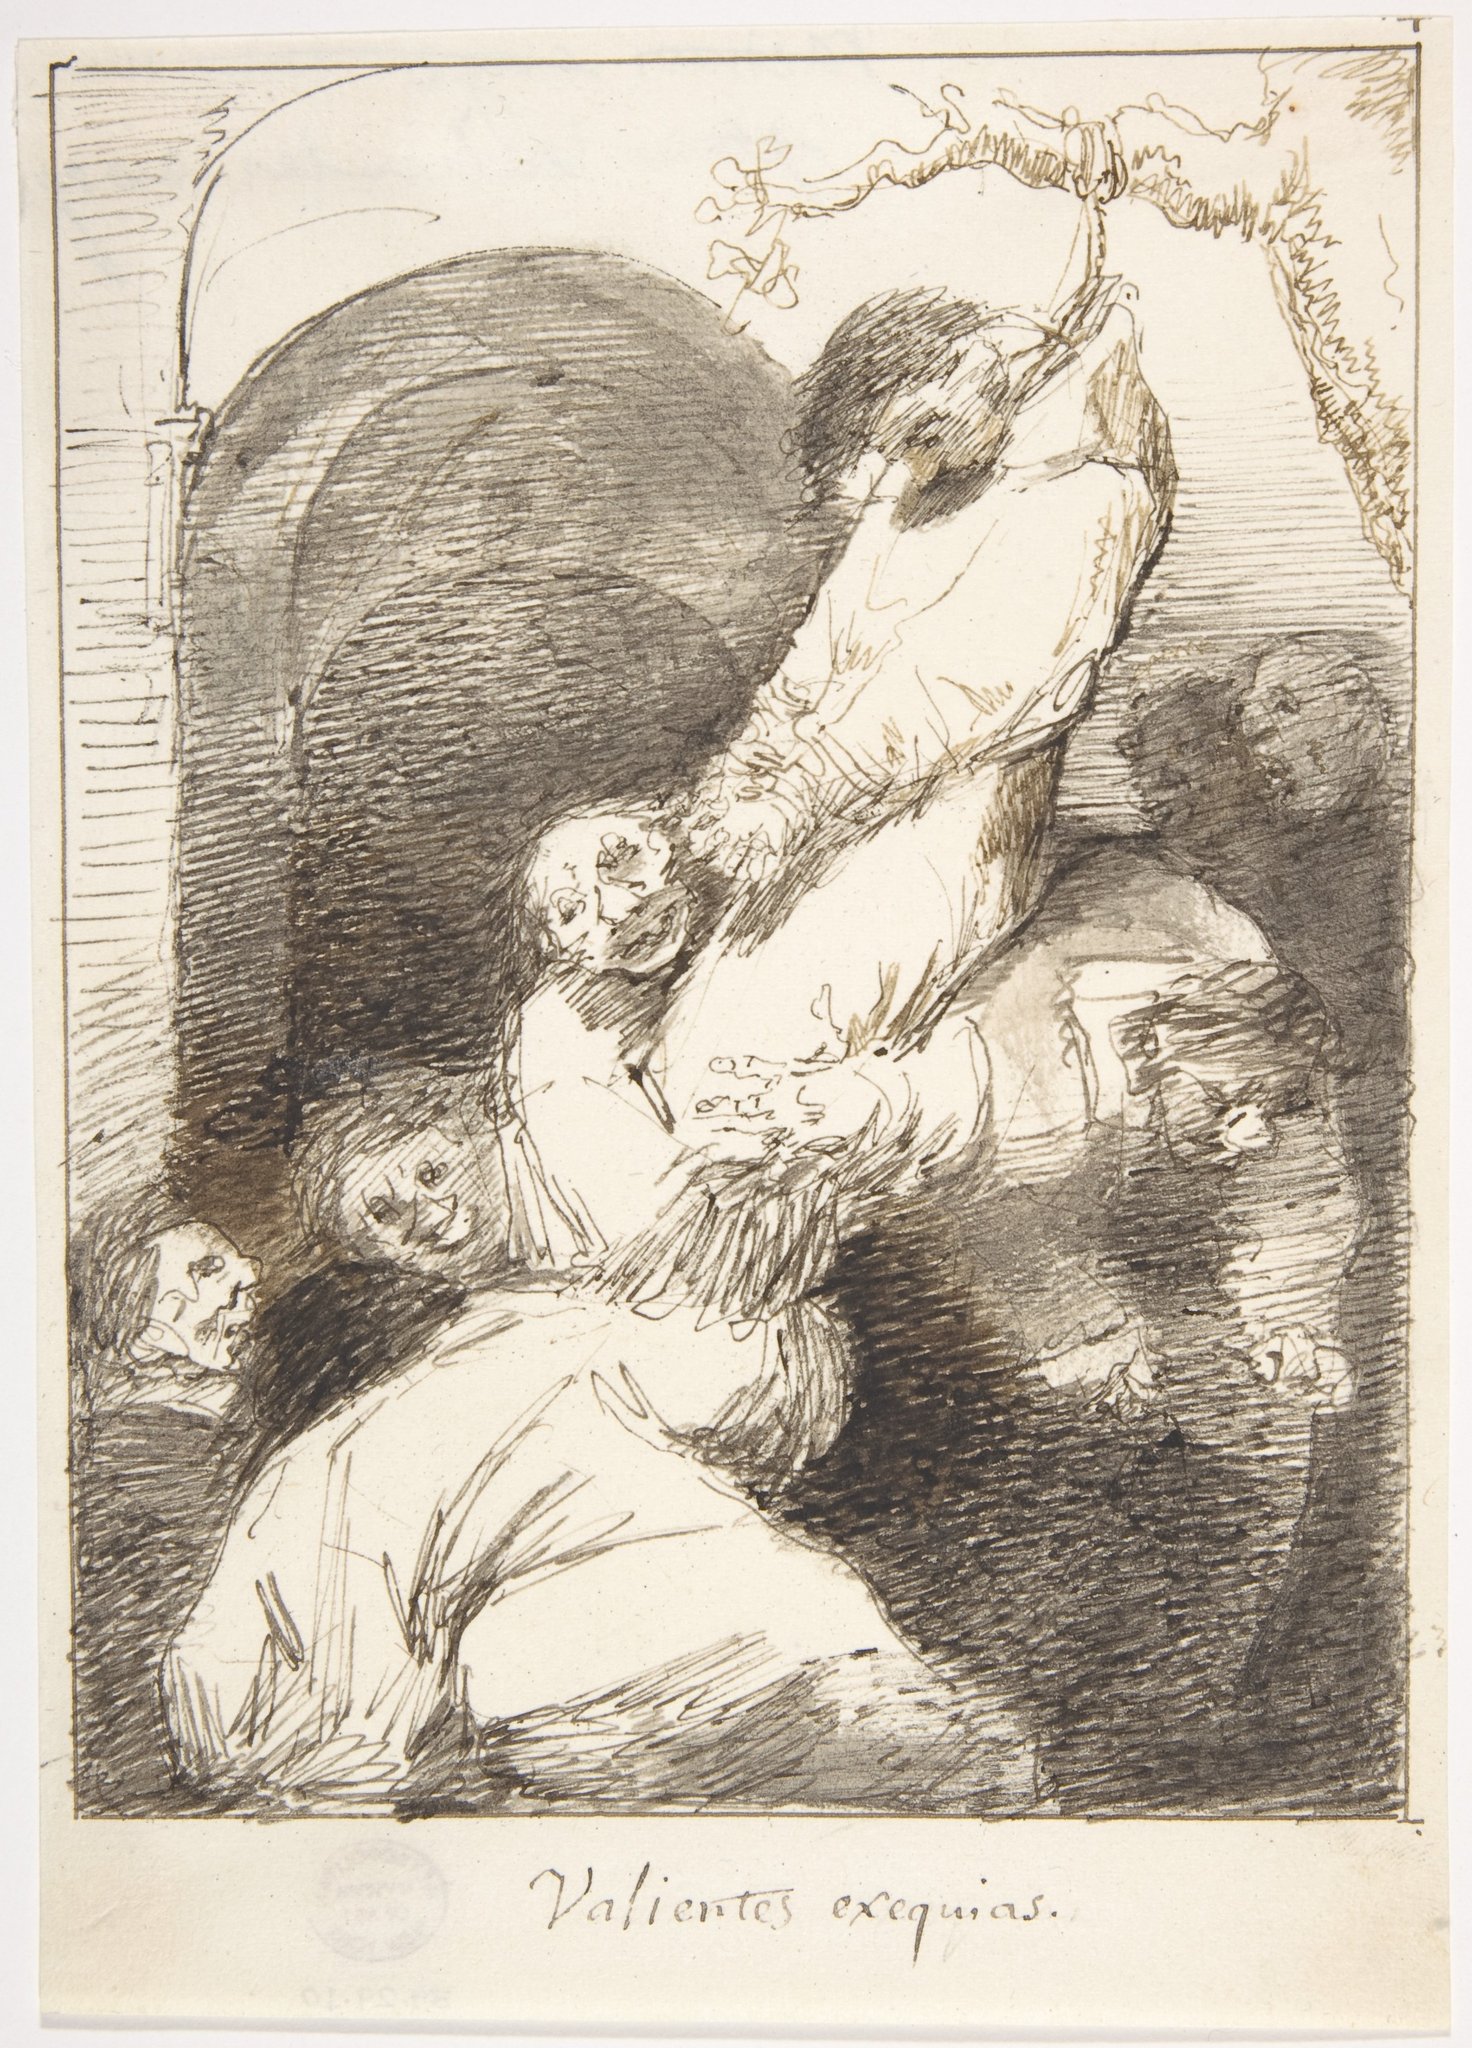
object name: drawing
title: A Funeral with Honors (Valientes exequias)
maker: leonardo alenza y nieto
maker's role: artist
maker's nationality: spanish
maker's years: 1807-1845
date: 1807-1845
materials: ink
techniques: pen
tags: men,funerals,death